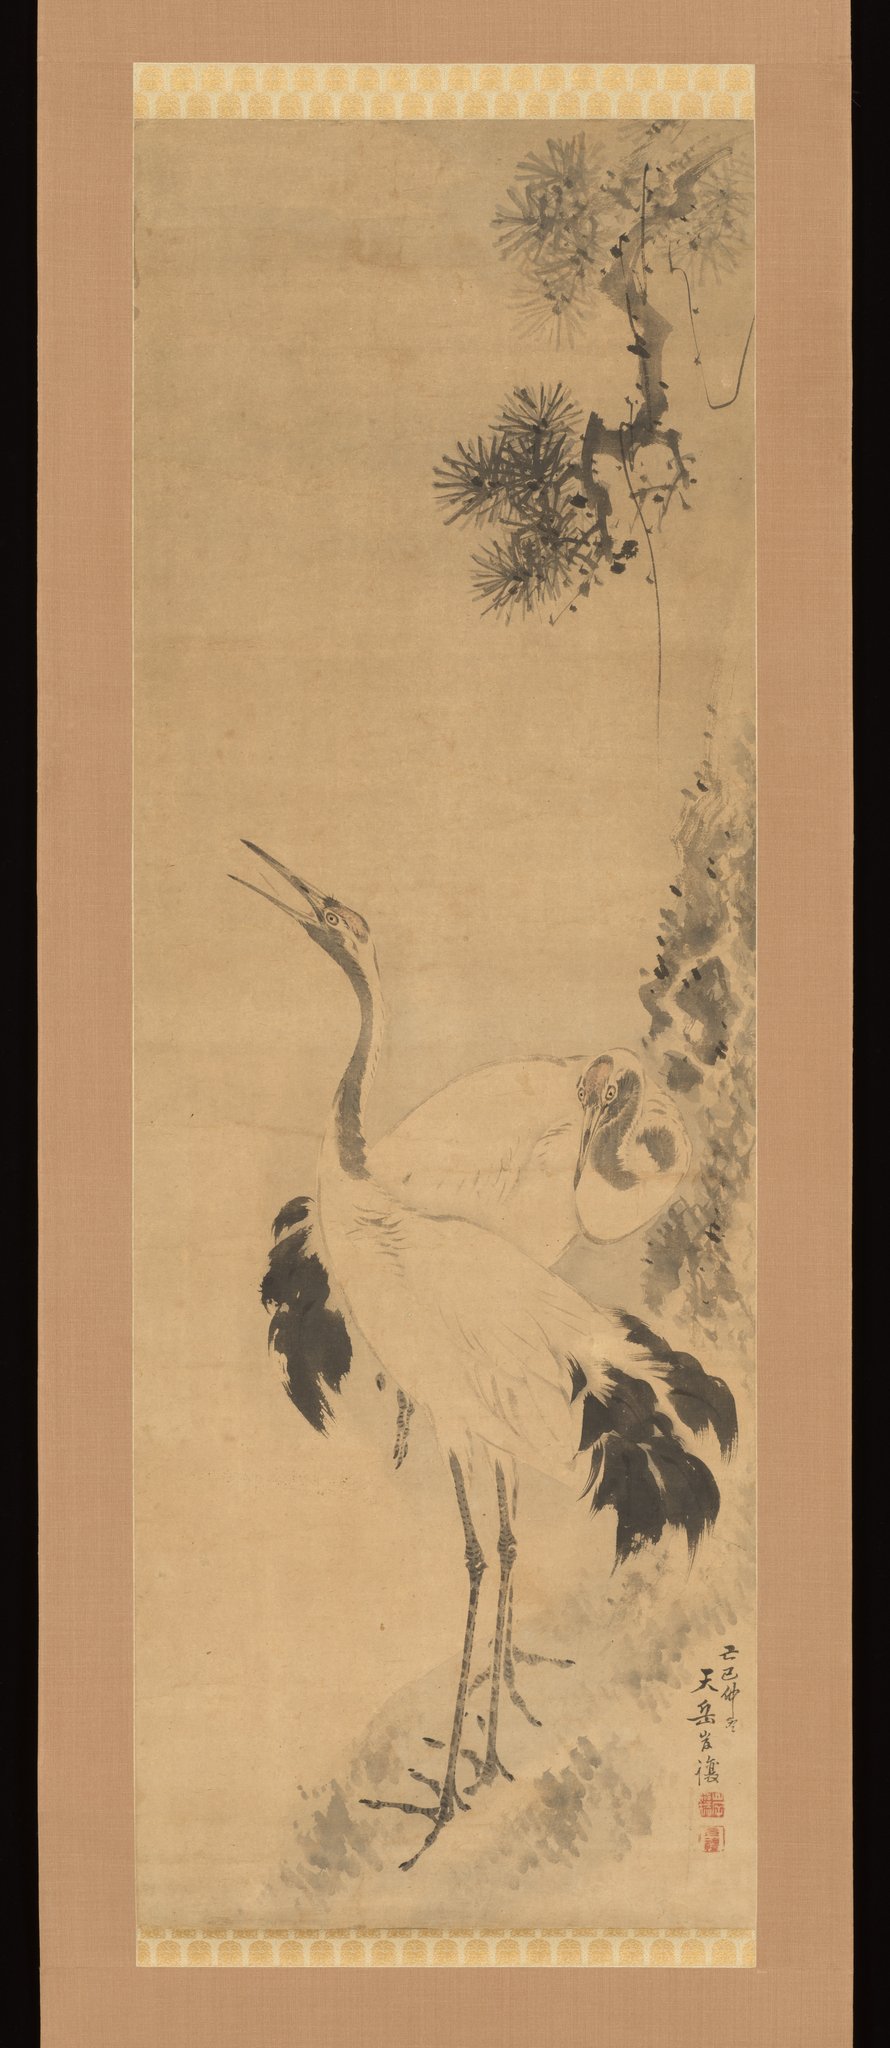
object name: hanging scroll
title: Two Birds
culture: japanese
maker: ganjō tengaku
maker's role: artist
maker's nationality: japanese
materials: ink, paper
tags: cranes